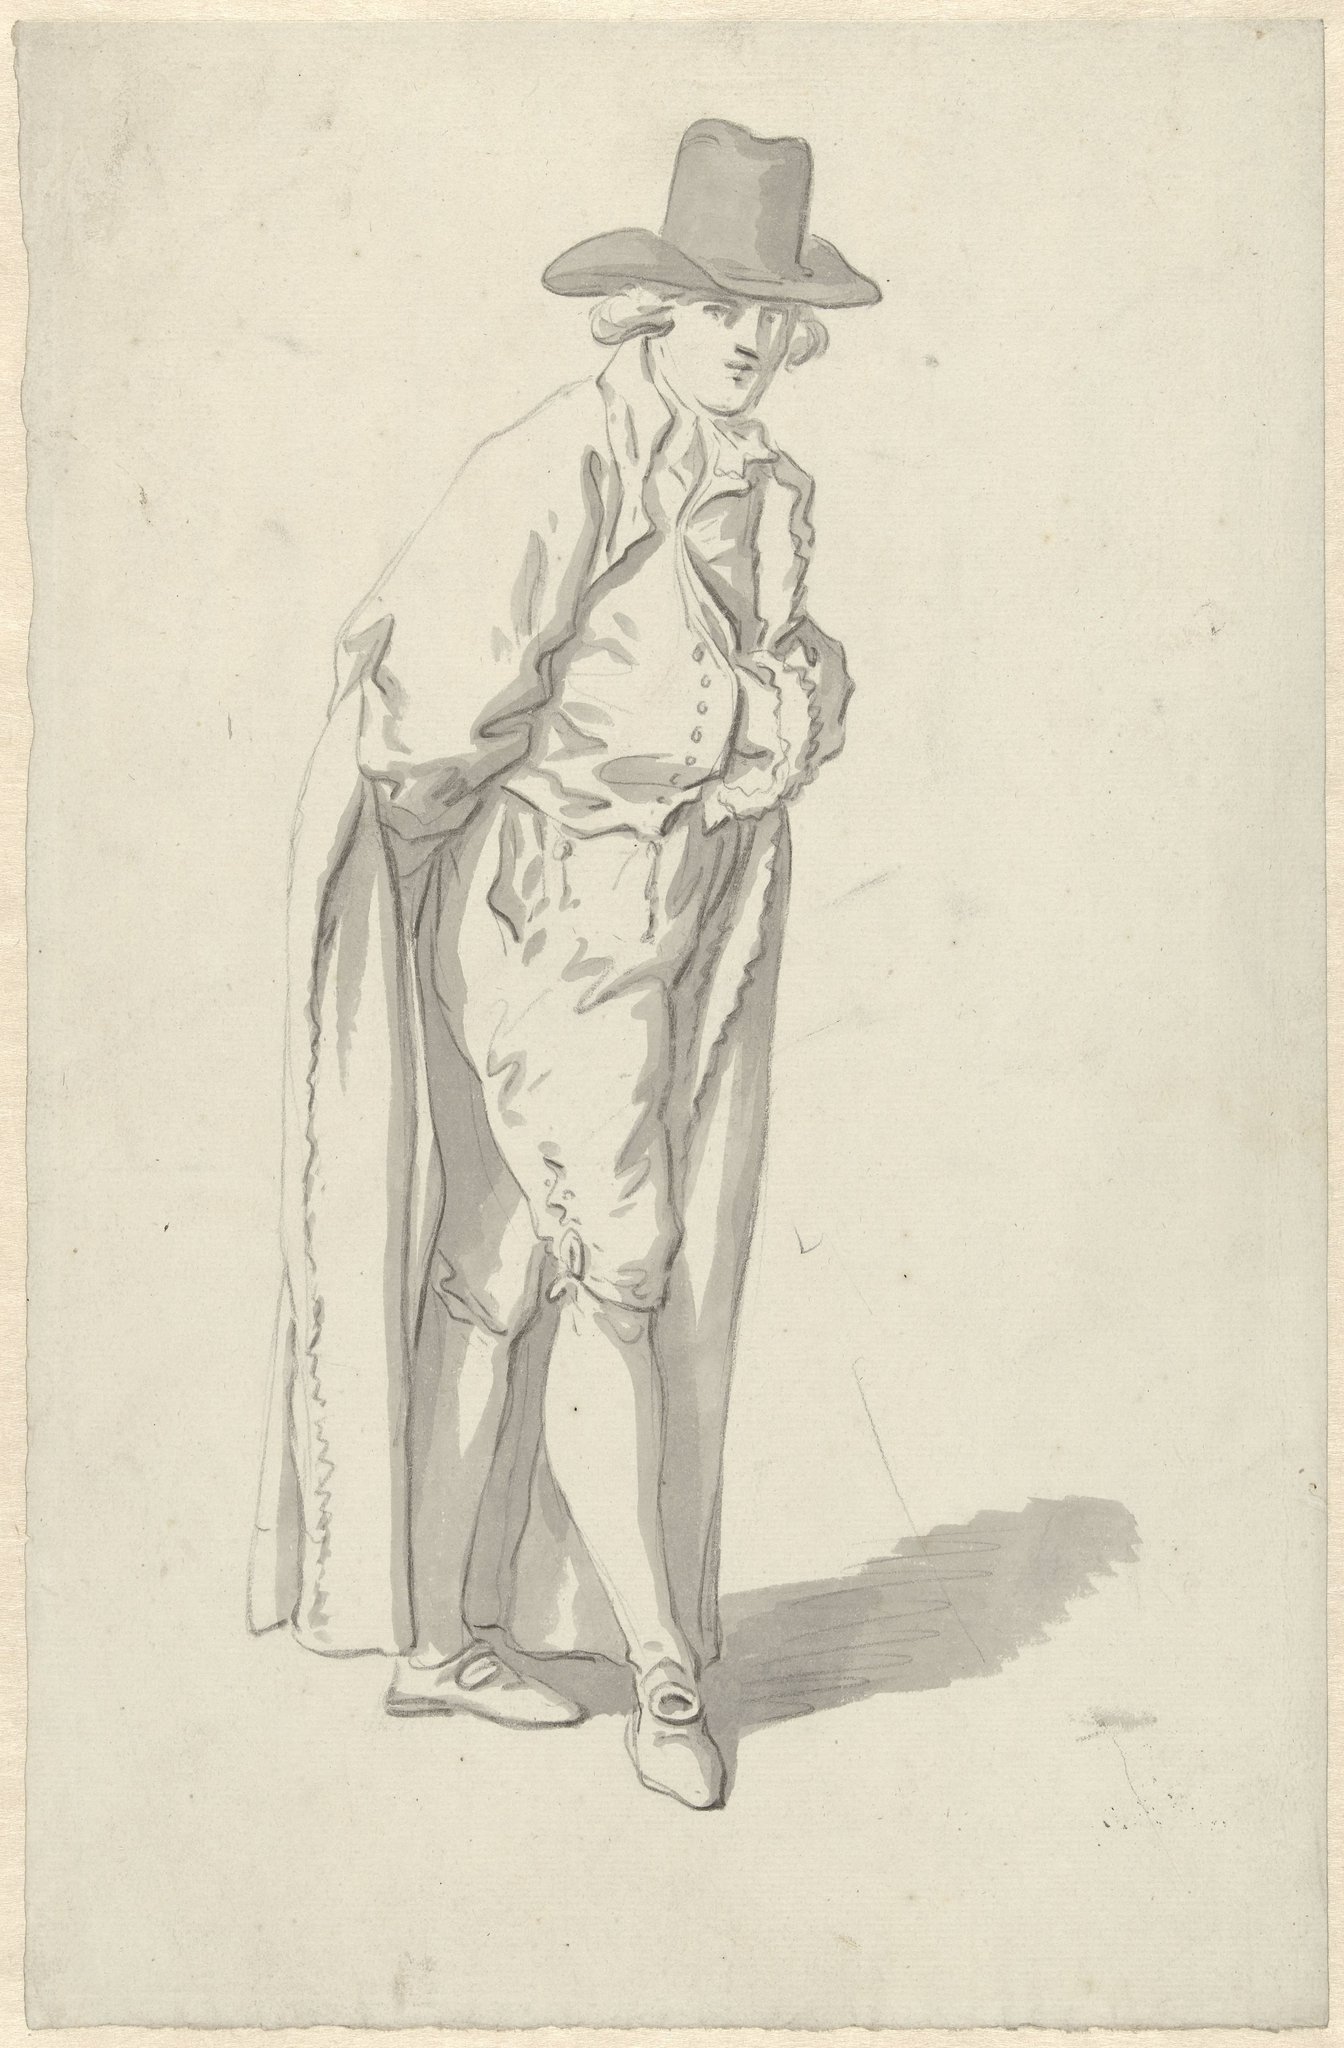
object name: drawing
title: Staande figuur in lange jas en hoed, linkerhand in zijn vest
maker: johannes ziesenis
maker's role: draughtsman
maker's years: 1770-1799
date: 1780-1799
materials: chalk, paper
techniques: brush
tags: postures of the human figure